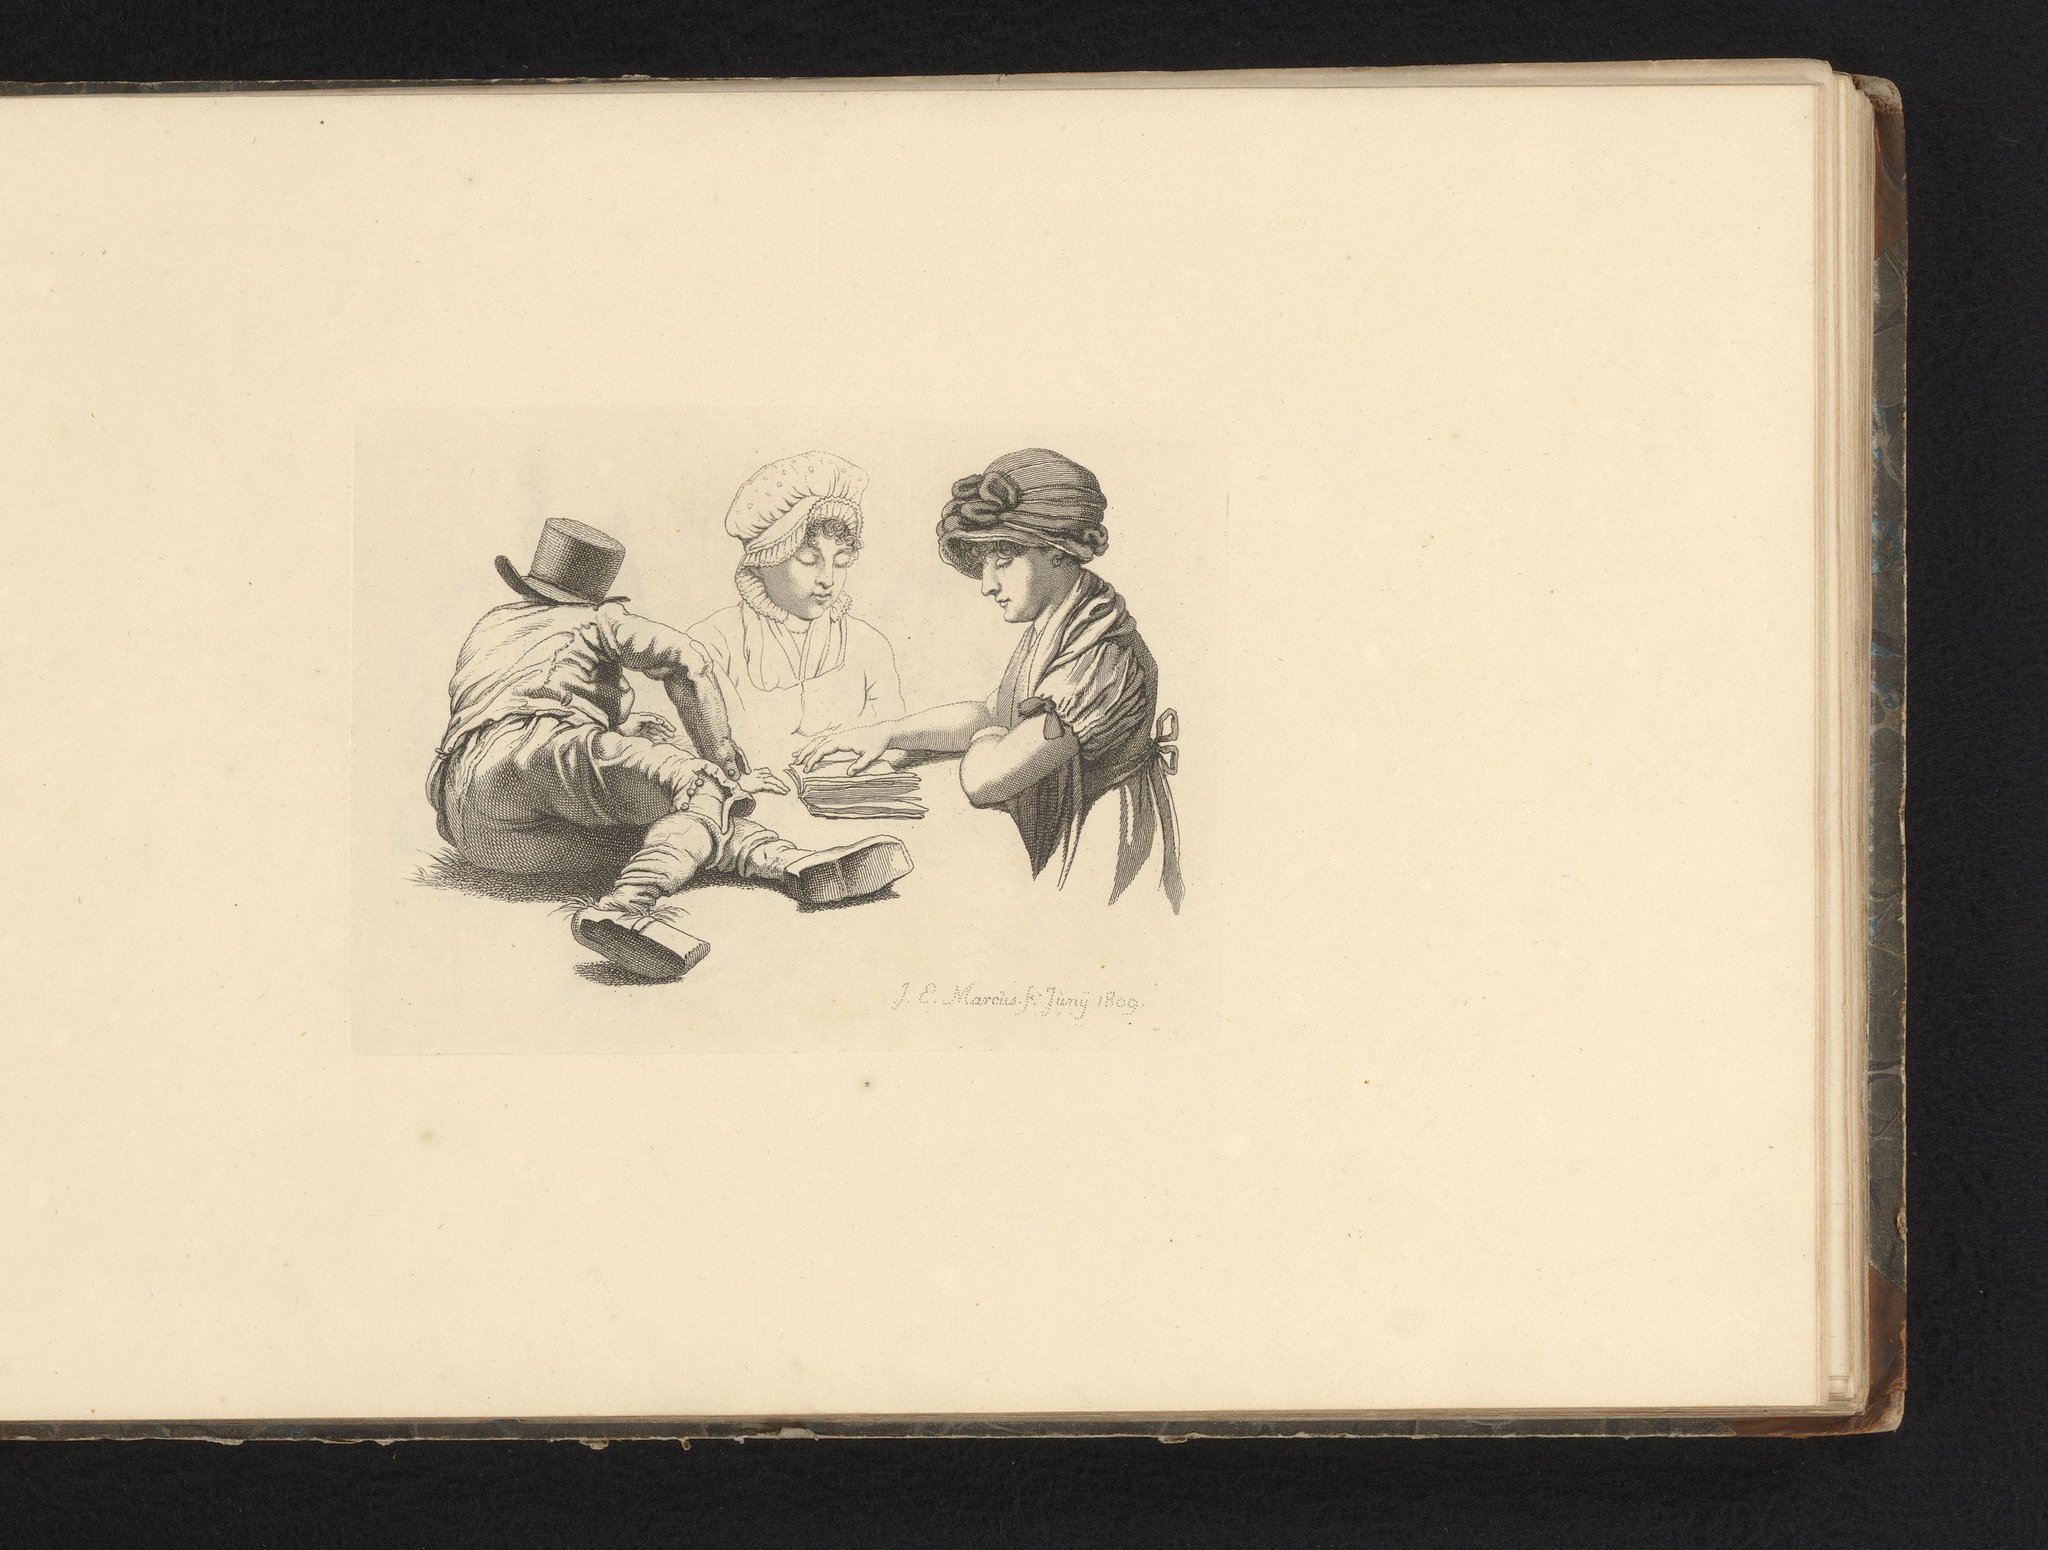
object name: print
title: Studiebeelden en fragmenten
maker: jacob ernst marcus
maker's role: draughtsman, print maker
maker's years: 1774-1826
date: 1806-1809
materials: paper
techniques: etching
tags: reading, sleeping on the ground, anonymous historical person portrayed - bb - woman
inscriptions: date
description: Deze prent maakt deel uit van een album.